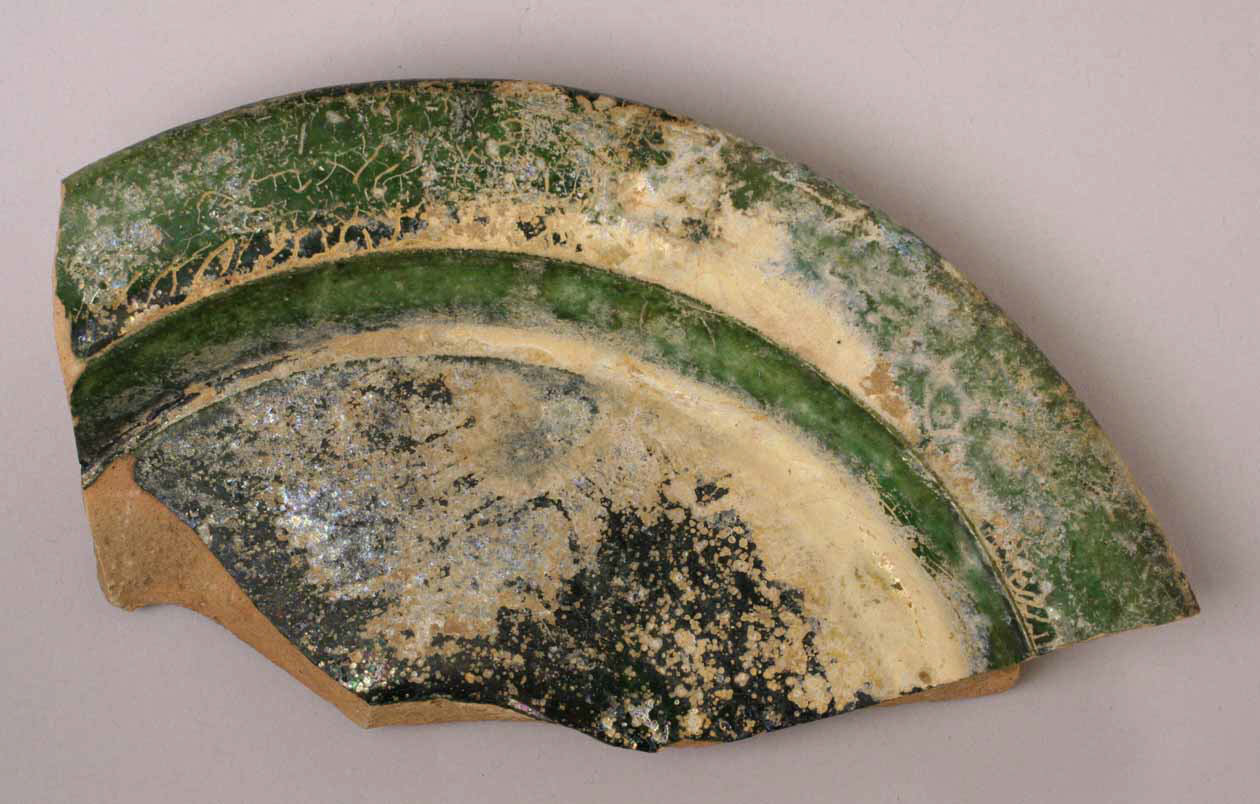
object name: fragment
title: Ceramic Fragment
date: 701-900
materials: earthenware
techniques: glazing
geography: iraq